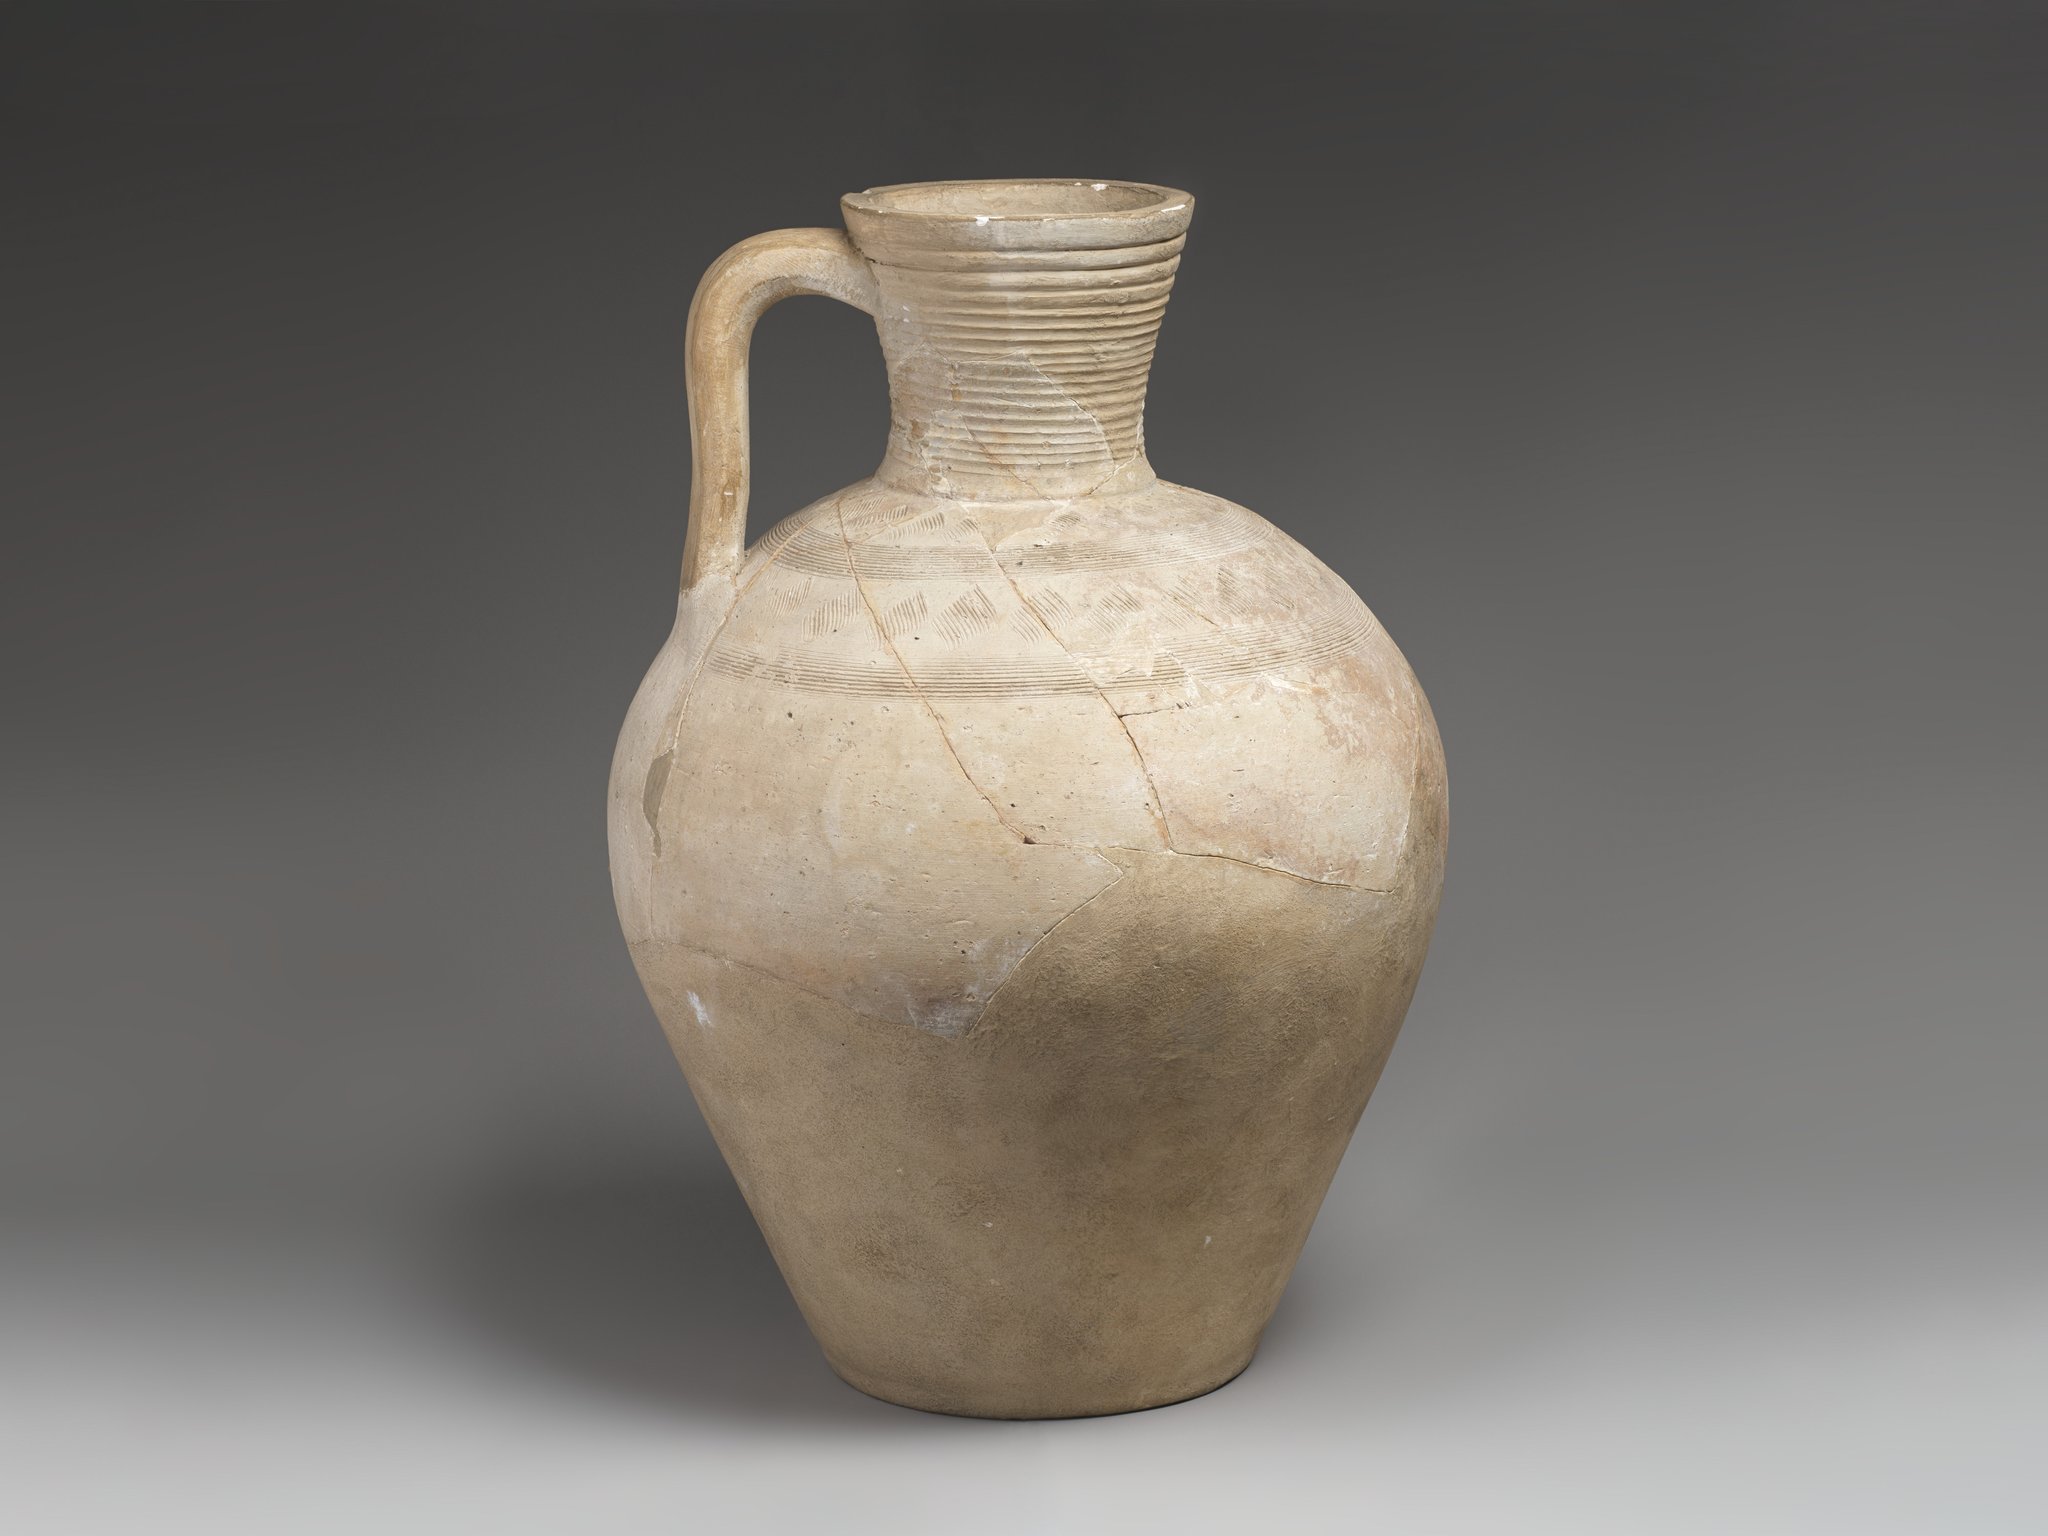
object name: jar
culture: sasanian or islamic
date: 601-800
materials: ceramic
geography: iran